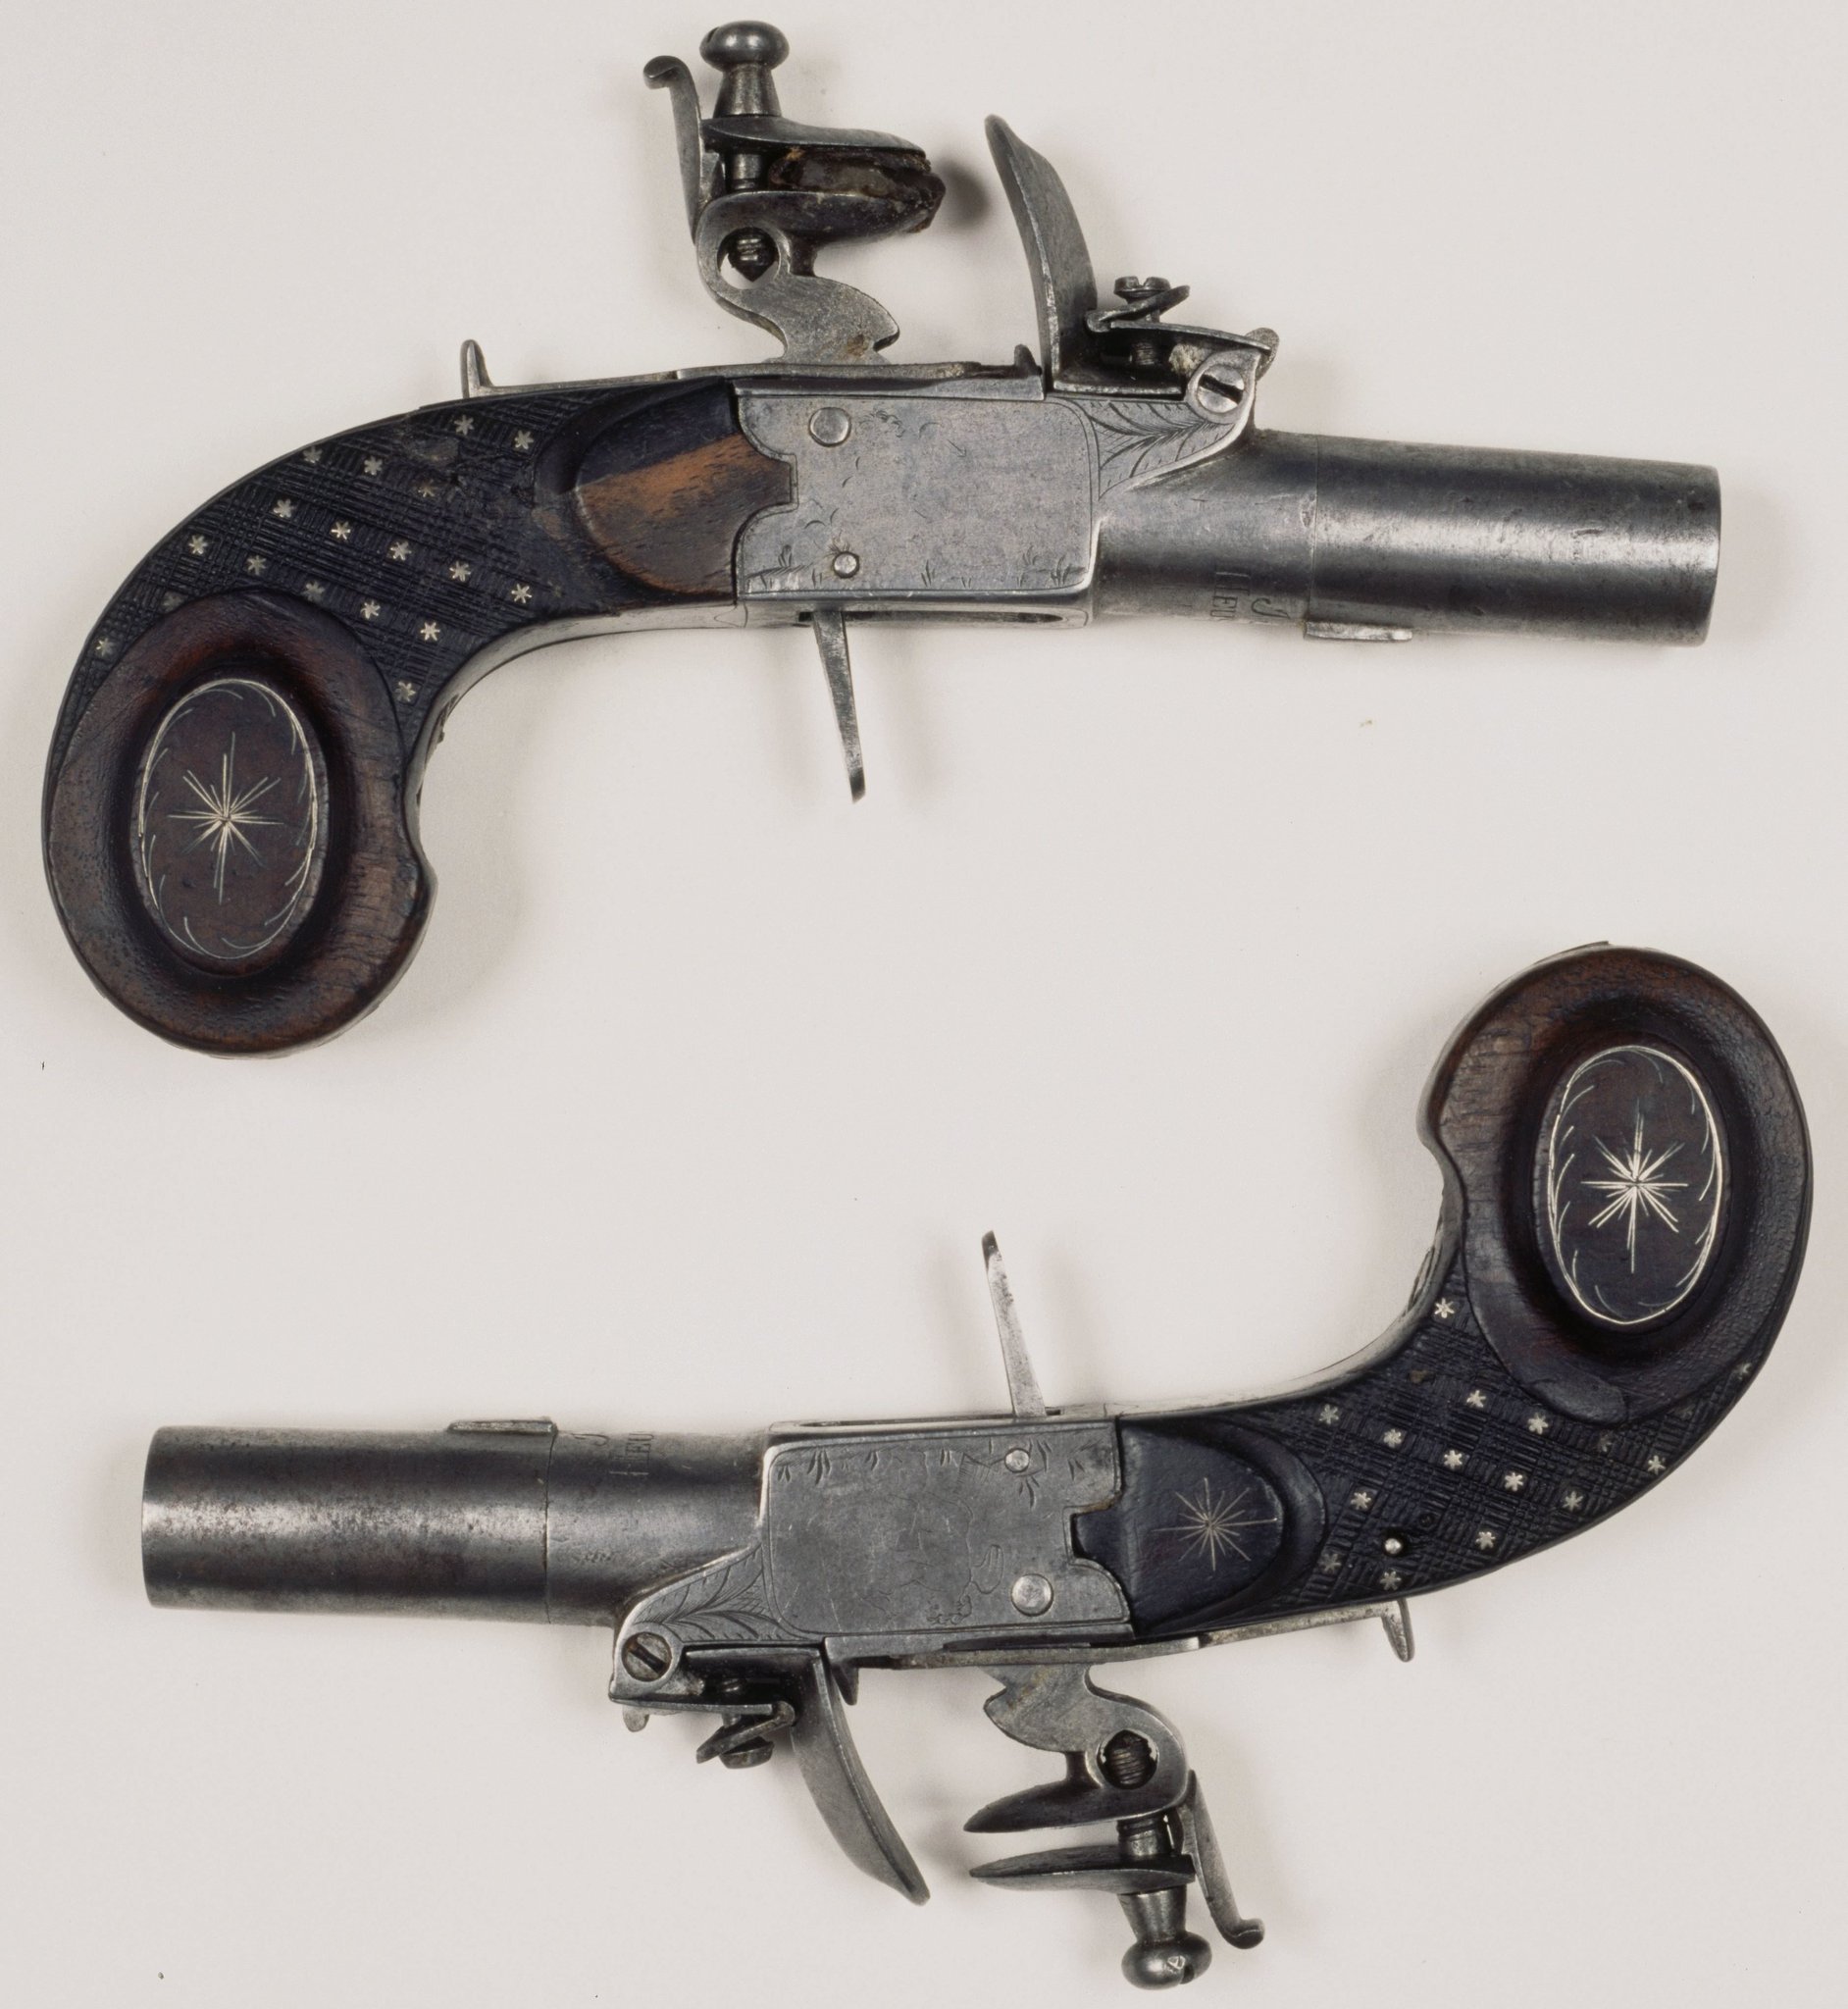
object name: flintlock pistol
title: Zakpistool met vuursteenslot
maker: Anonymous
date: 1775-1825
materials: iron, silver, wood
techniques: engraving, inlay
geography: western europe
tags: netherlands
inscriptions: mark: ‘F.B. Heuseux’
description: Zakpistool met vuursteenslot, ijzeren ronde gladde loop met ijzeren slotplaat en houten kolf. Onderzijde van de kolf is glad met een ingekerfde ster en lofwerk maar heeft een geribbelde bovenkant met stermotieven. De slotplaat zit met een ijzeren schroef aan de kolf bevestigd, in de plaat is cupido gegraveerd. Andere zijde is vlak met aan de randen lofwerk. Onderaan de loop is de naam 'F.B. Heuseux gegraveerd. De rechte ijzeren trekker kan ingeklapt worden.